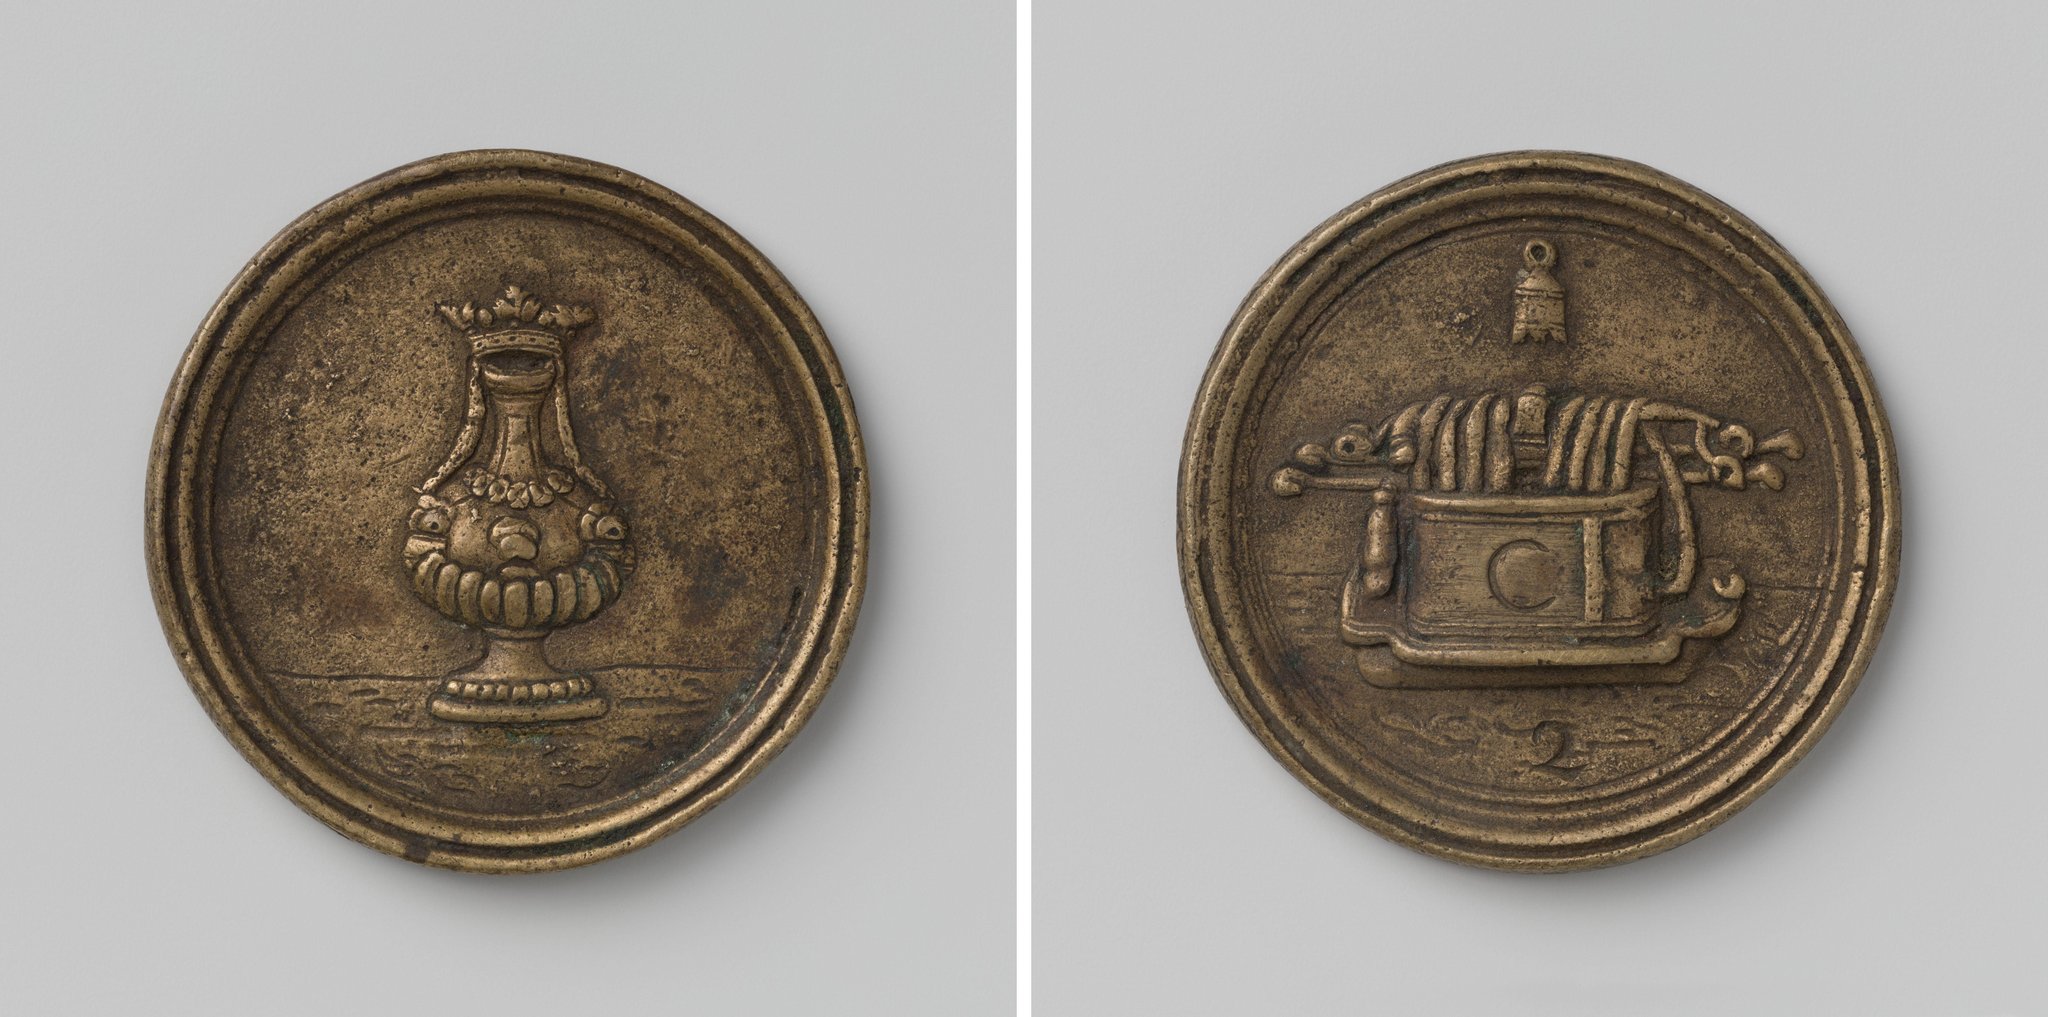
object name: medal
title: Vlissingen, brandspuitpenning van spuit C met no. 2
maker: Anonymous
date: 1680-1800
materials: brass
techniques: casting, engraving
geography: flushing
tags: flushing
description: Messing penning. Voorzijde: gekroond fles. Keerzijde: brandspuit onder bel [?] boven cijfer 2; op zijde van brandspuit: letter C